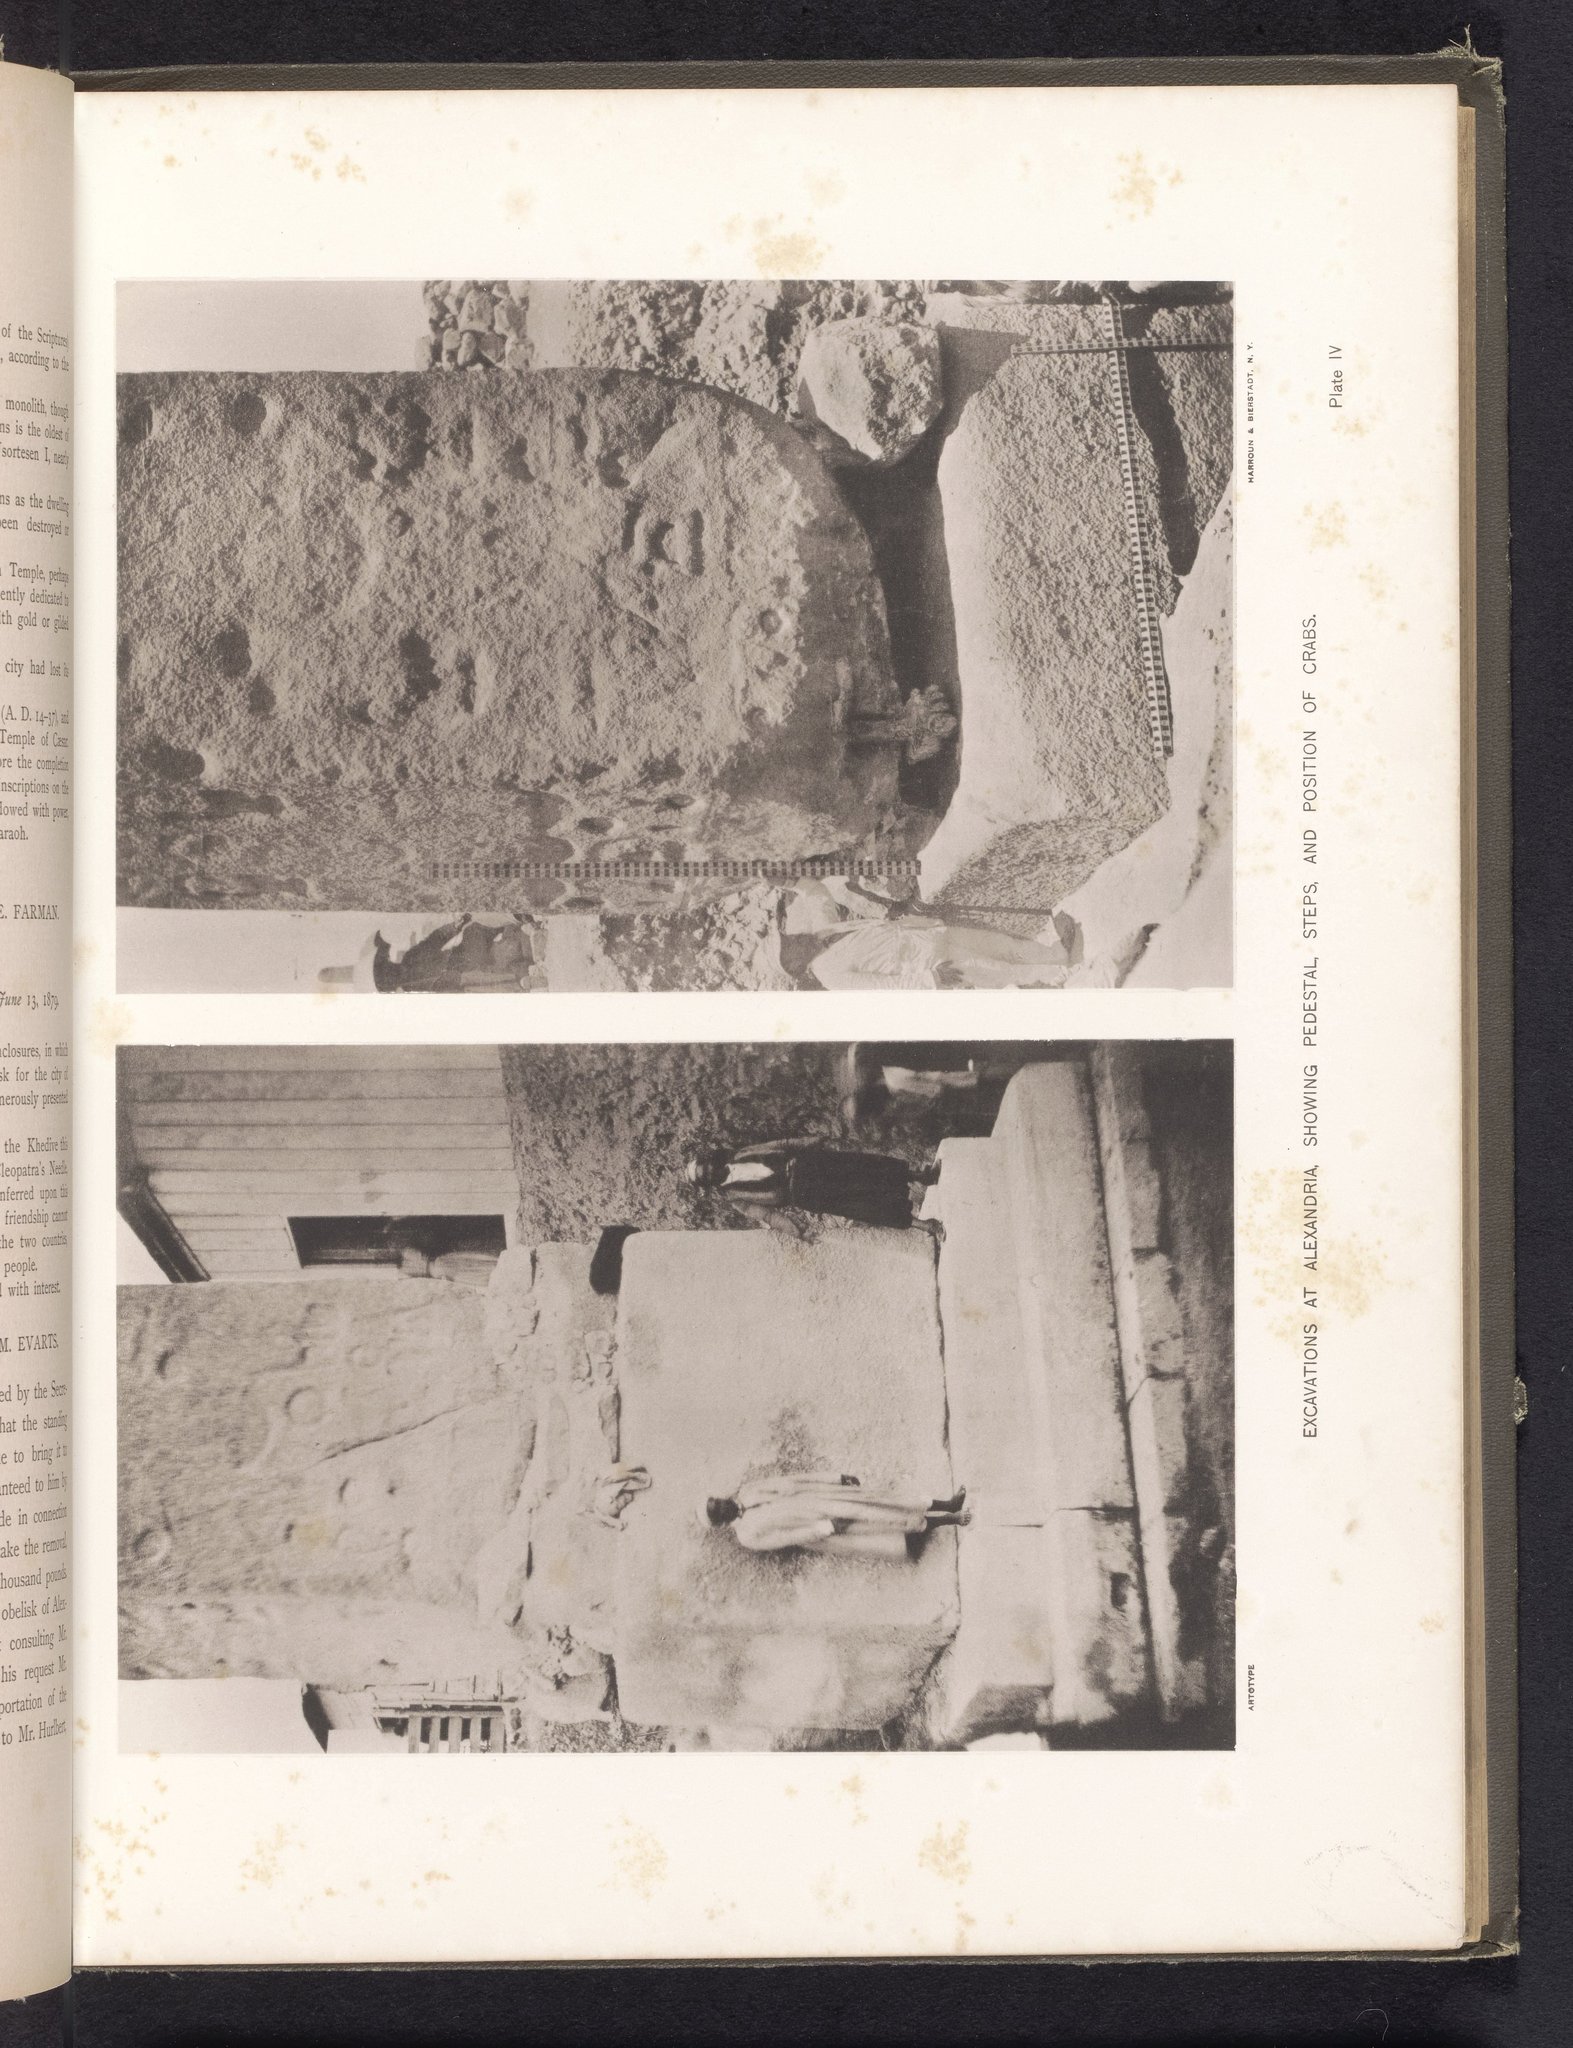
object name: photomechanical print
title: Excavations at Alexandria, showing pedestal, steps, and position of crabs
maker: Anonymous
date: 1879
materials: paper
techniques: photograph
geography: new york city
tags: obelisk, needle, base (~ column, pillar)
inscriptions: number: ‘Plate IV’